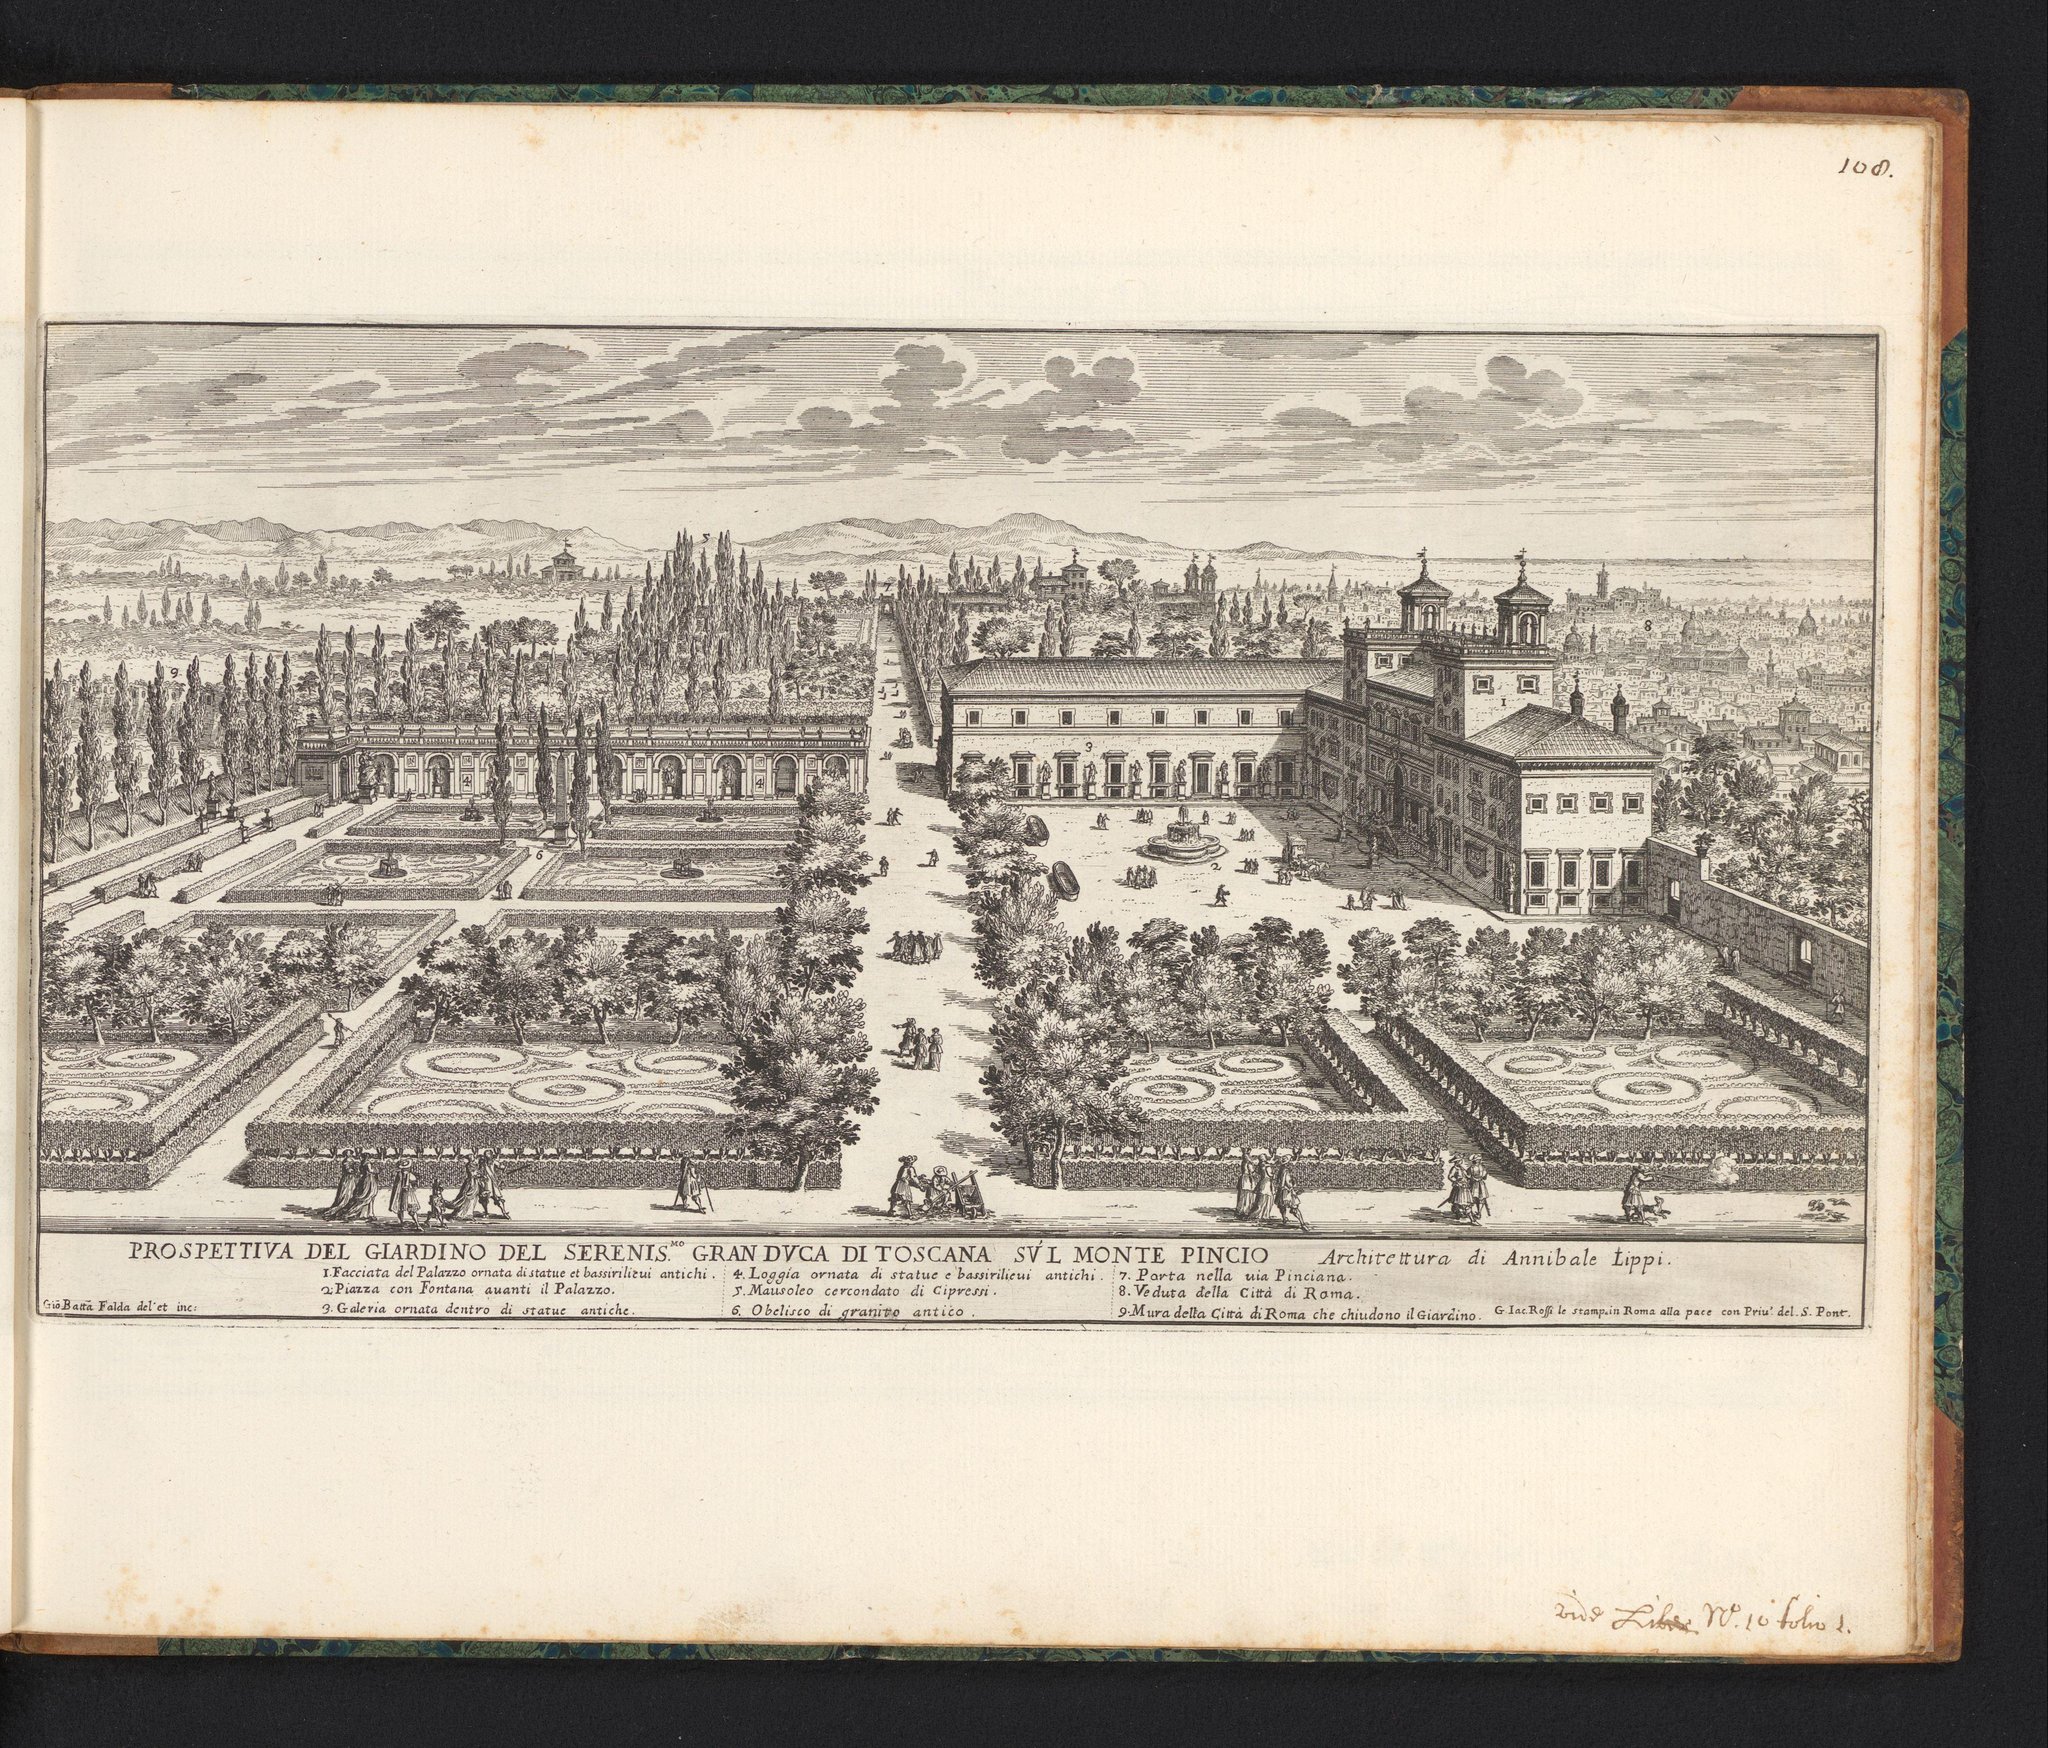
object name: print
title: Gezicht op de Villa Medici en tuin te Rome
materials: paper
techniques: etching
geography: italy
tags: plan, map of garden, garden, hôtel, i.e. small palace in city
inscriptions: number: ‘108’, inscription: ‘Ende lib. No. 10. folio 1.’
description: Gezicht op de Villa Medici en tuin te Rome. Mensen flaneren in de tuin. In de ondermarge de titel en een verklarende lijst met nummers. Prent maakt deel uit van een album.